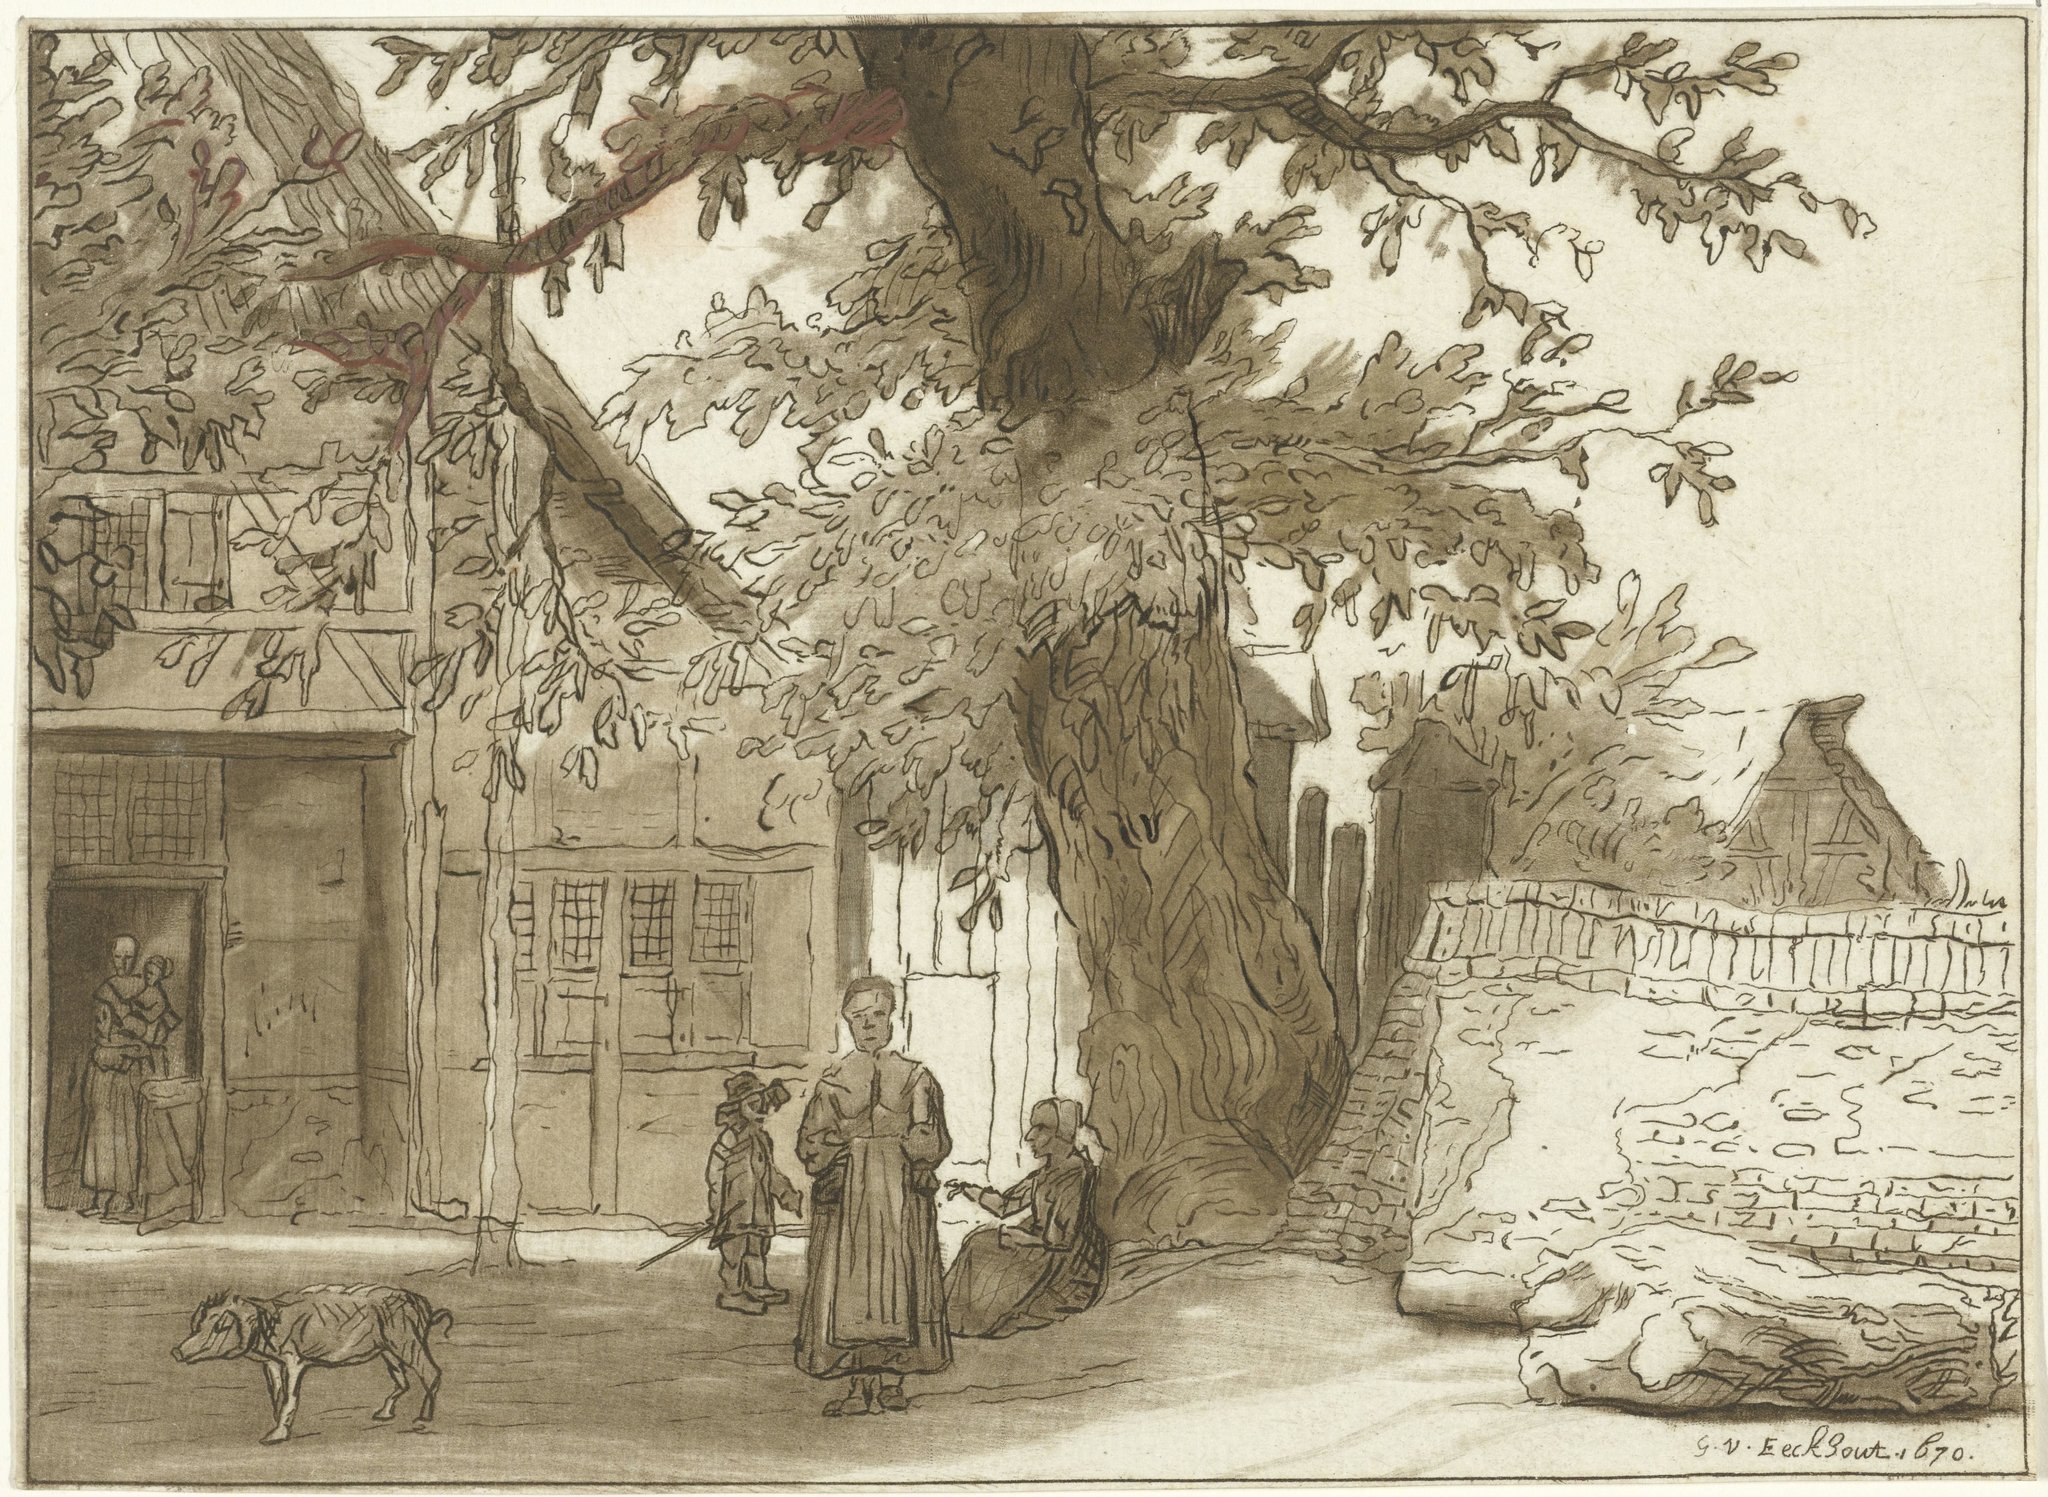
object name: print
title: Dorpsgezicht met grote boom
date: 1759-1760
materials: paper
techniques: etching, roulette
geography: amsterdam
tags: trees, pig, village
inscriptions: inscription: ‘Aan d heer J v [?] geoffreerd / G vd Eekhout del Ploos v Amstel F 1757’, collector's mark: Lugt 240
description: Herberg 'Zur blauen Hand am Kirchhof' te Anrath. In de deuropening een vrouw met kind op de arm. Naast de herberg een grote boom en enkele figuren daaronder. Links een varken.